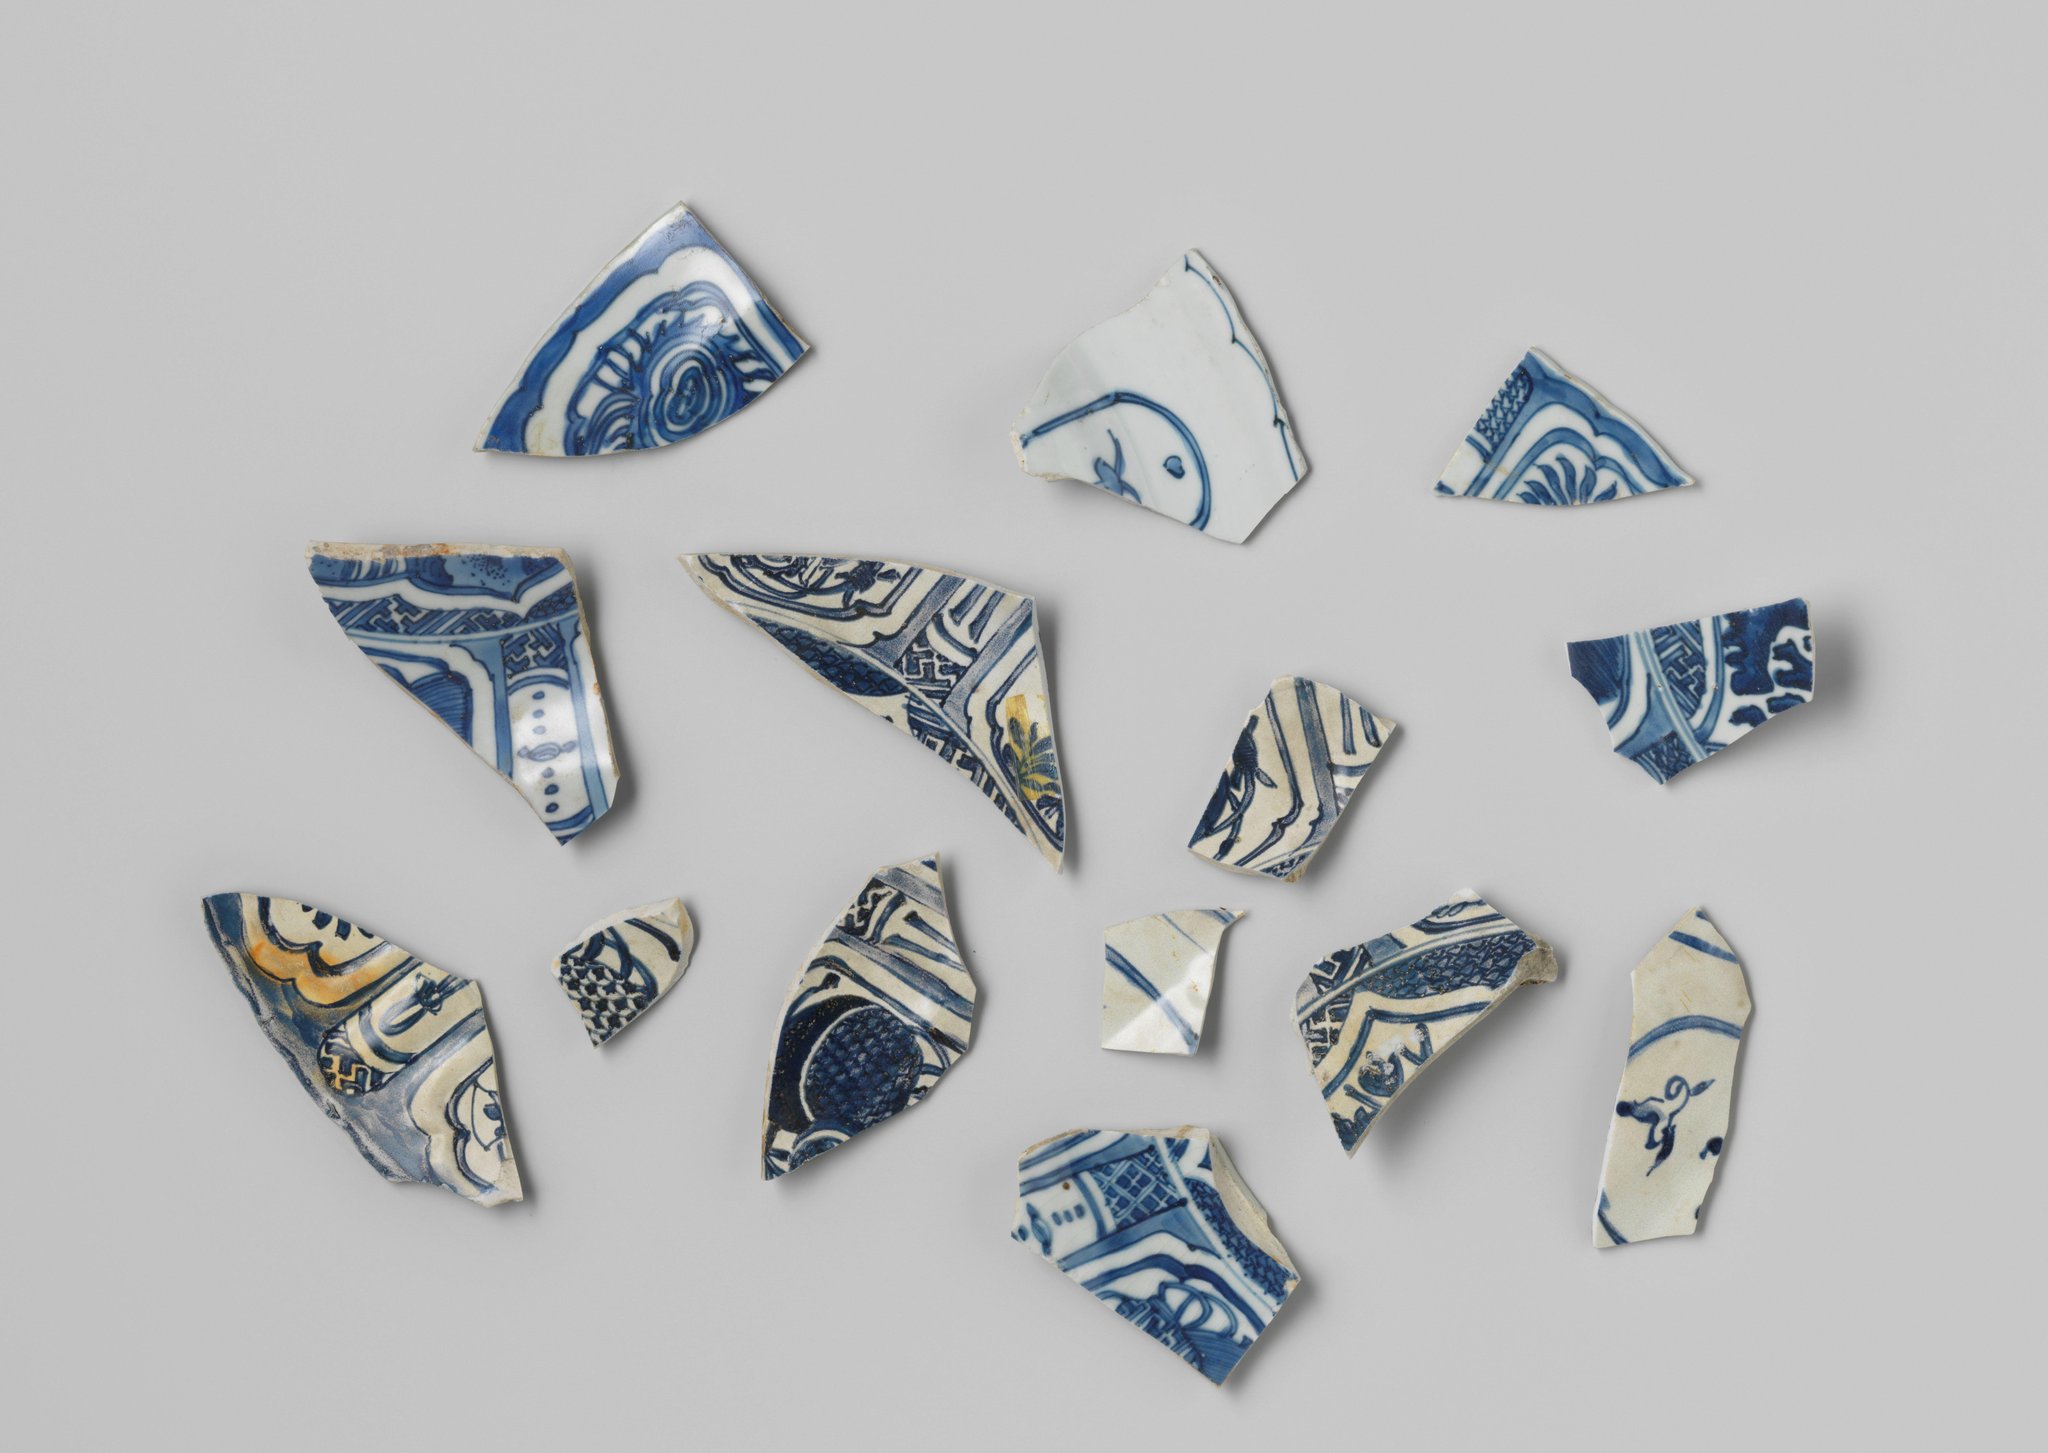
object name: plate dish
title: Scherven van borden uit V.O.C.-schip de 'Witte Leeuw'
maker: Anonymous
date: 1613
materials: bone china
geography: jingdezhen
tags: verenigde oostindische compagnie, sint-helena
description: Scherven van borden uit V.O.C.-schip de 'Witte Leeuw' van kraakporselein.